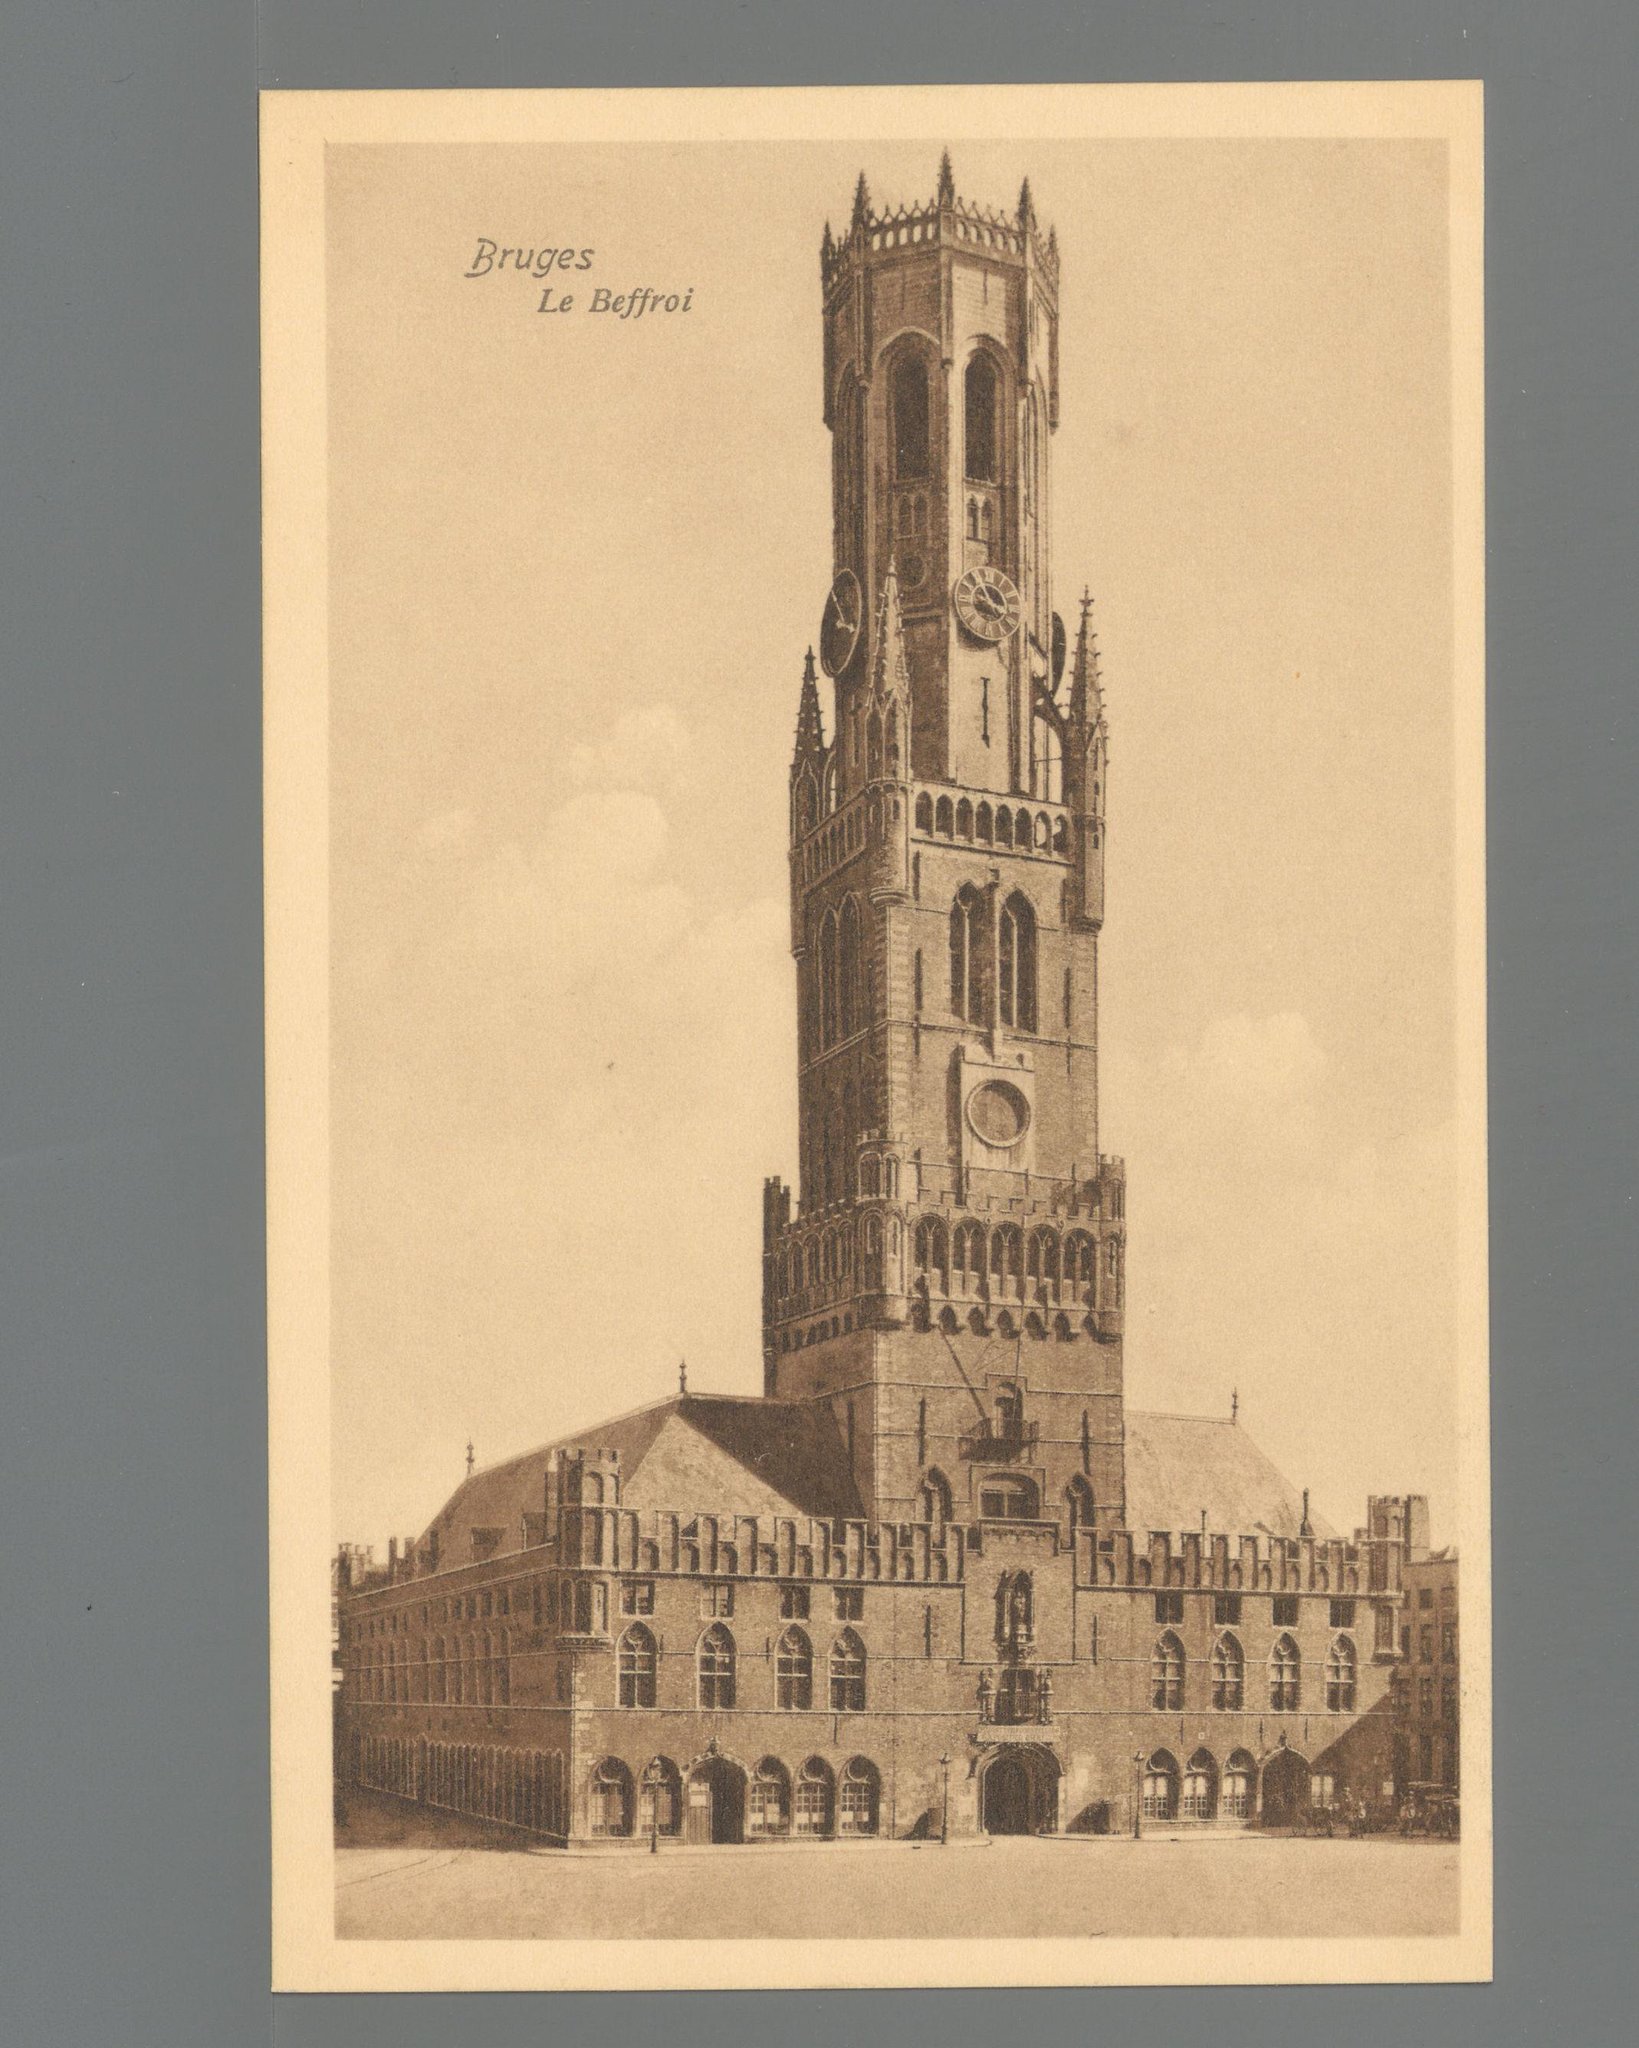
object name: ansichtkaart, prentbriefkaart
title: Bruges. Le Beffroi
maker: Anonymous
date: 1906-1930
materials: cardboard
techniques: photograph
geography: bruges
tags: square, place, circus, etc., tower, clock tower ~ monumental adornment